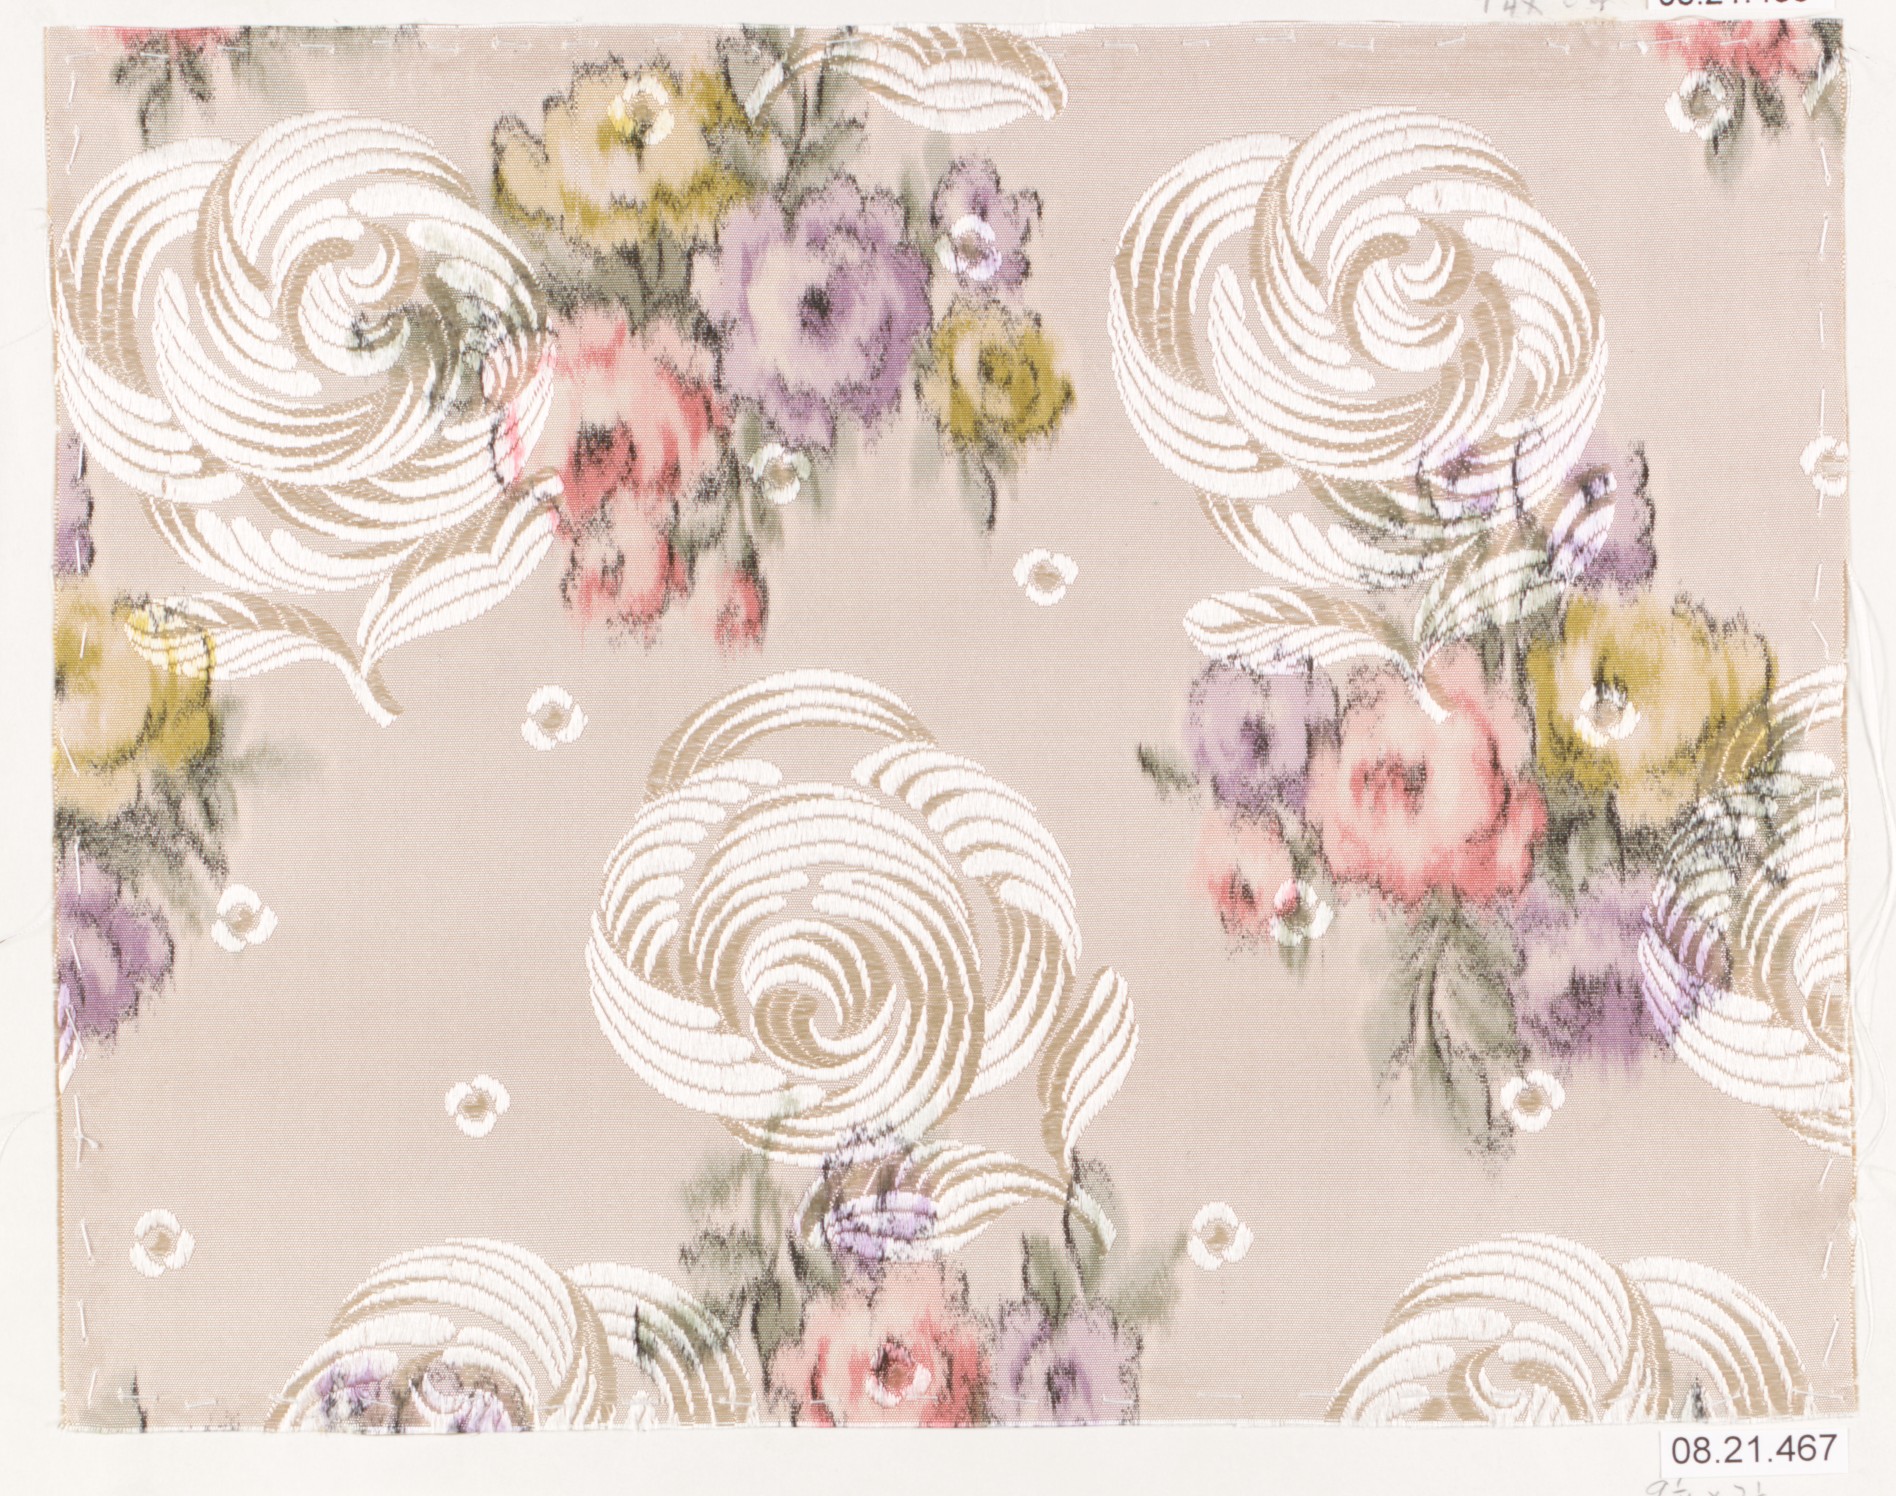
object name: textile sample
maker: Anonymous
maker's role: designer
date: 1900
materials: silk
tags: flowers